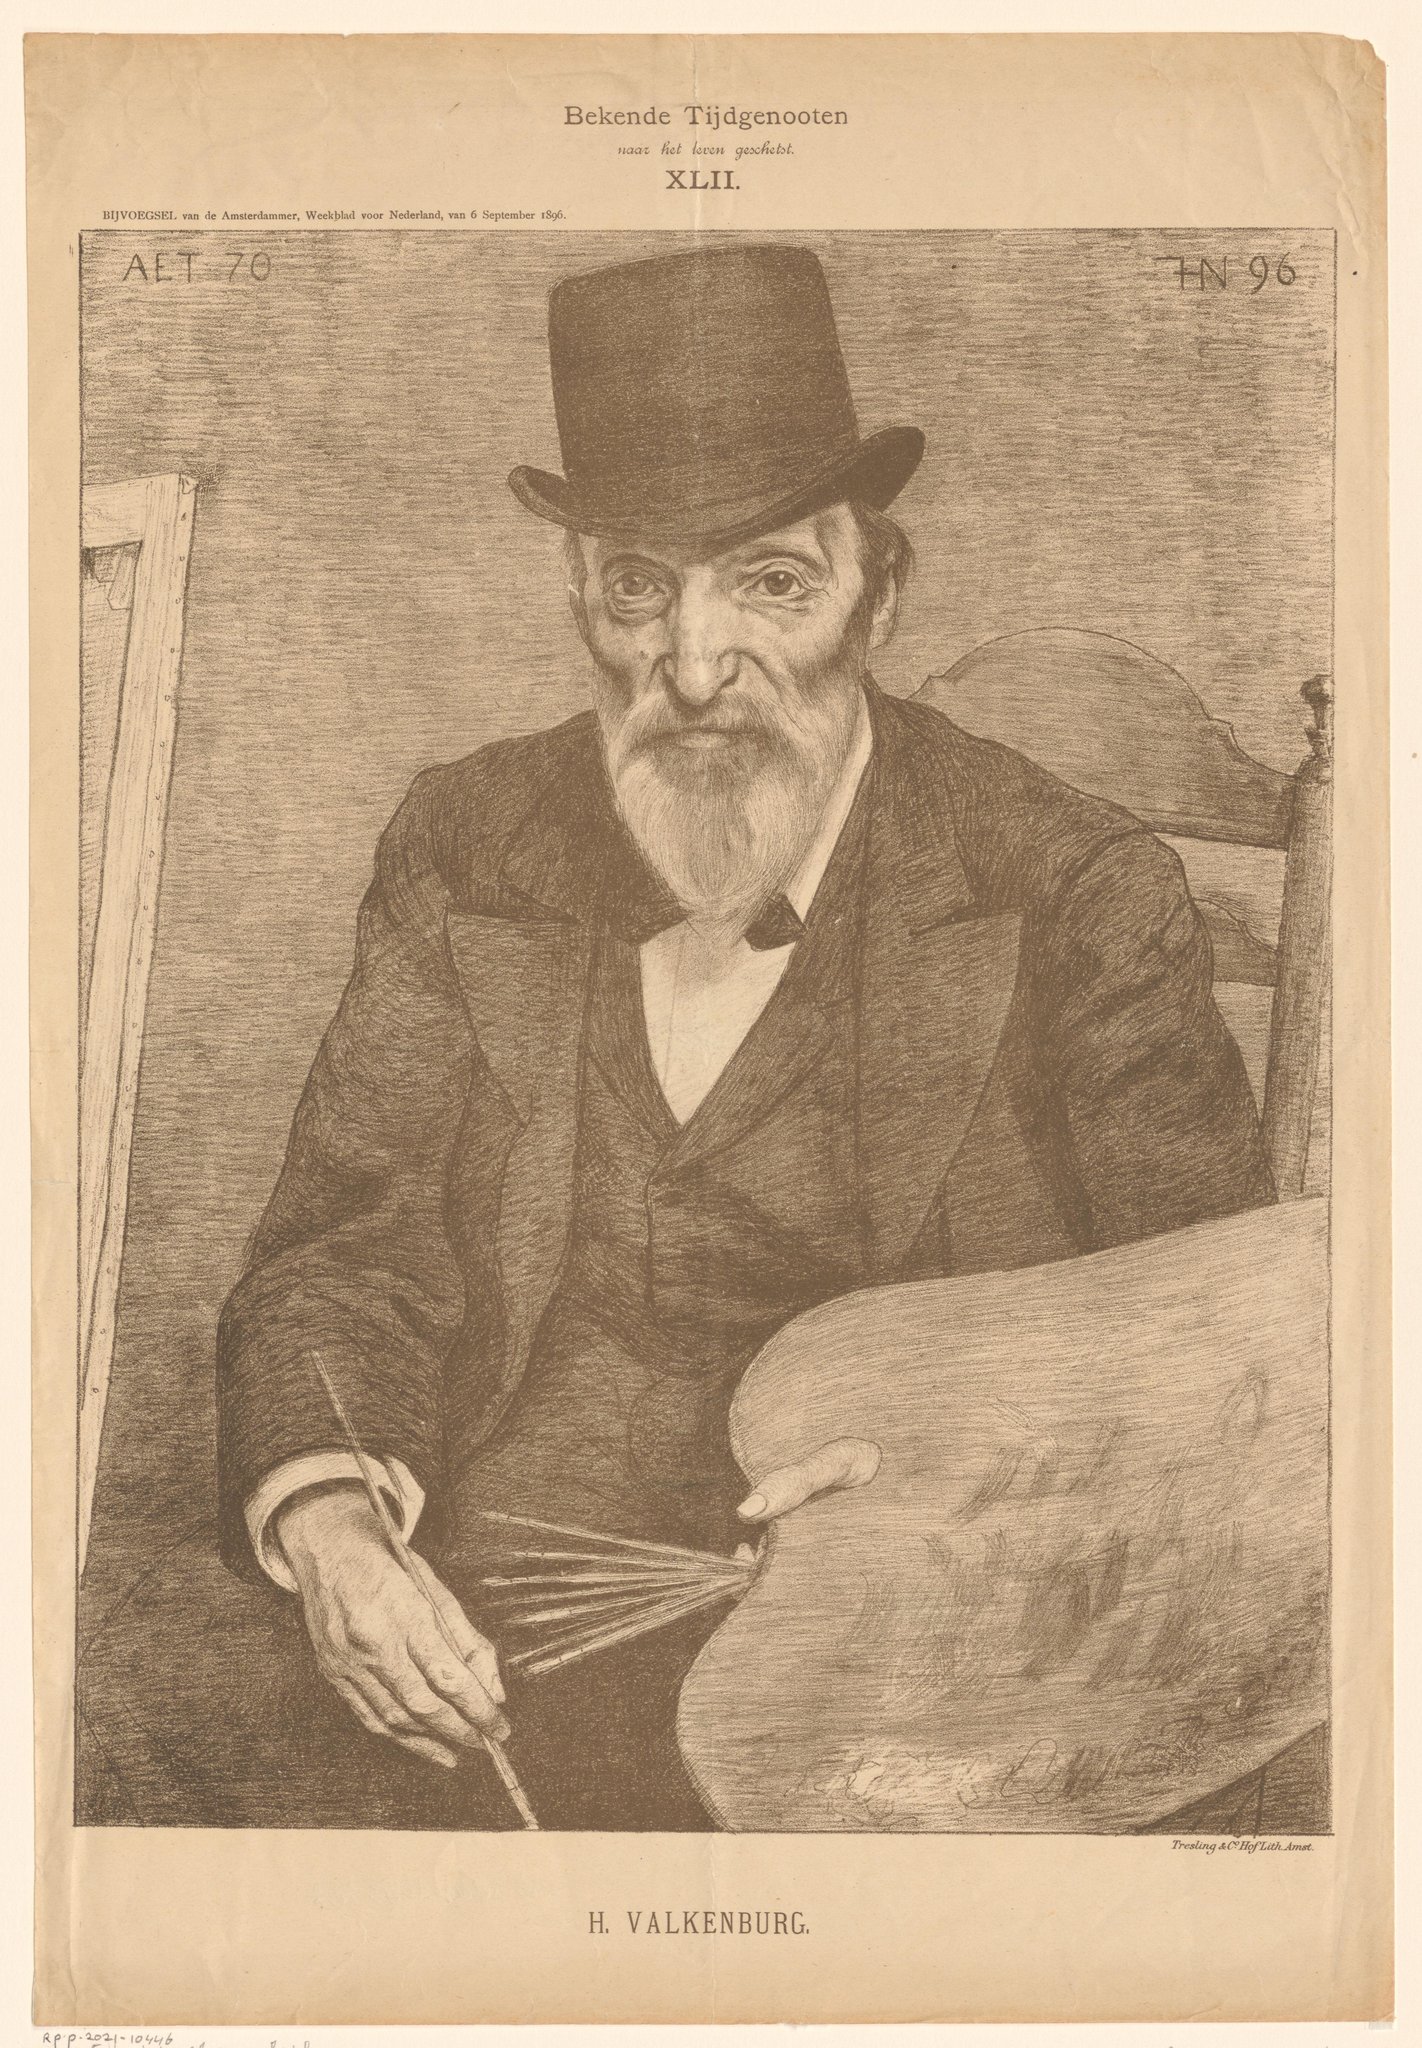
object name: print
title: Bekende tijdgenooten naar het leven geschetst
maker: ferdinand hart nibbrig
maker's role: draughtsman, painter, print maker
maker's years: 1866-1915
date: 1896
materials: paper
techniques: lithograph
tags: amsterdam, painter, draughtsman, historical persons, portrait, self-portrait of artist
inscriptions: collector's mark: Lugt 2228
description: Een portret van kunstenaar Hendrik Valkenburg op zeventigjarige leeftijd, met een schildersezel in zijn hand.